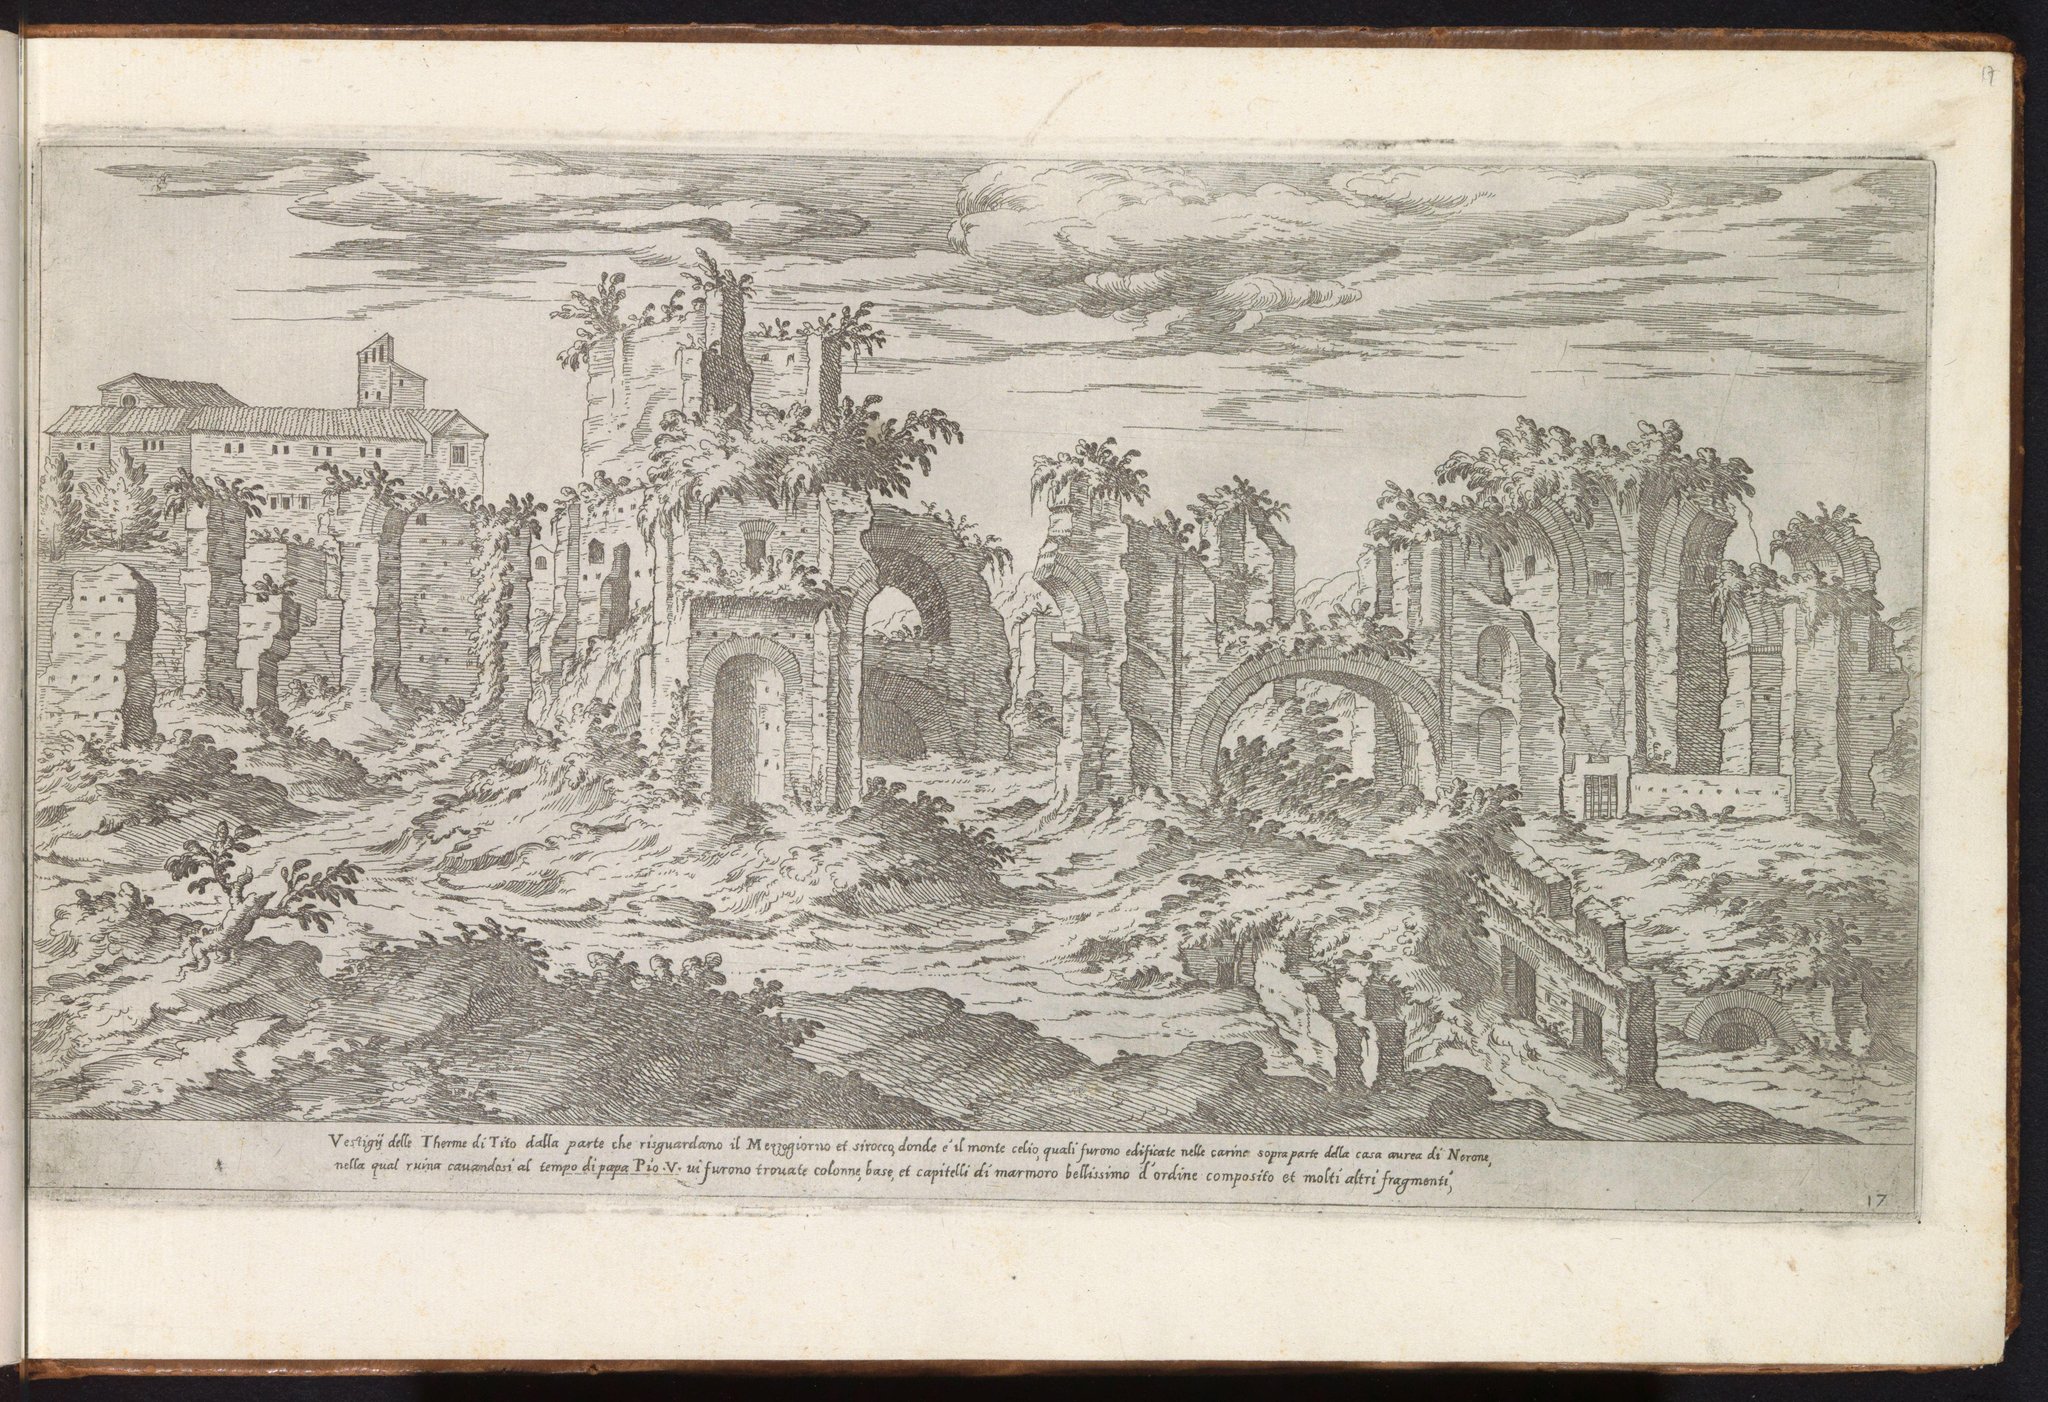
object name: album leaf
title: Ruïnes van de Thermen van Titus te Rome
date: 1575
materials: paper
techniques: engraving, etching, intaglio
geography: rome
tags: city-view, and landscape with man-made constructions, ruin of a building ~ architecture, landscape with ruins, public baths - aa - in the open air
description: Gezicht op de ruïnes van de Thermen van Titus te Rome. Onderschrift in het Italiaans. Prent maakt deel uit van een album.